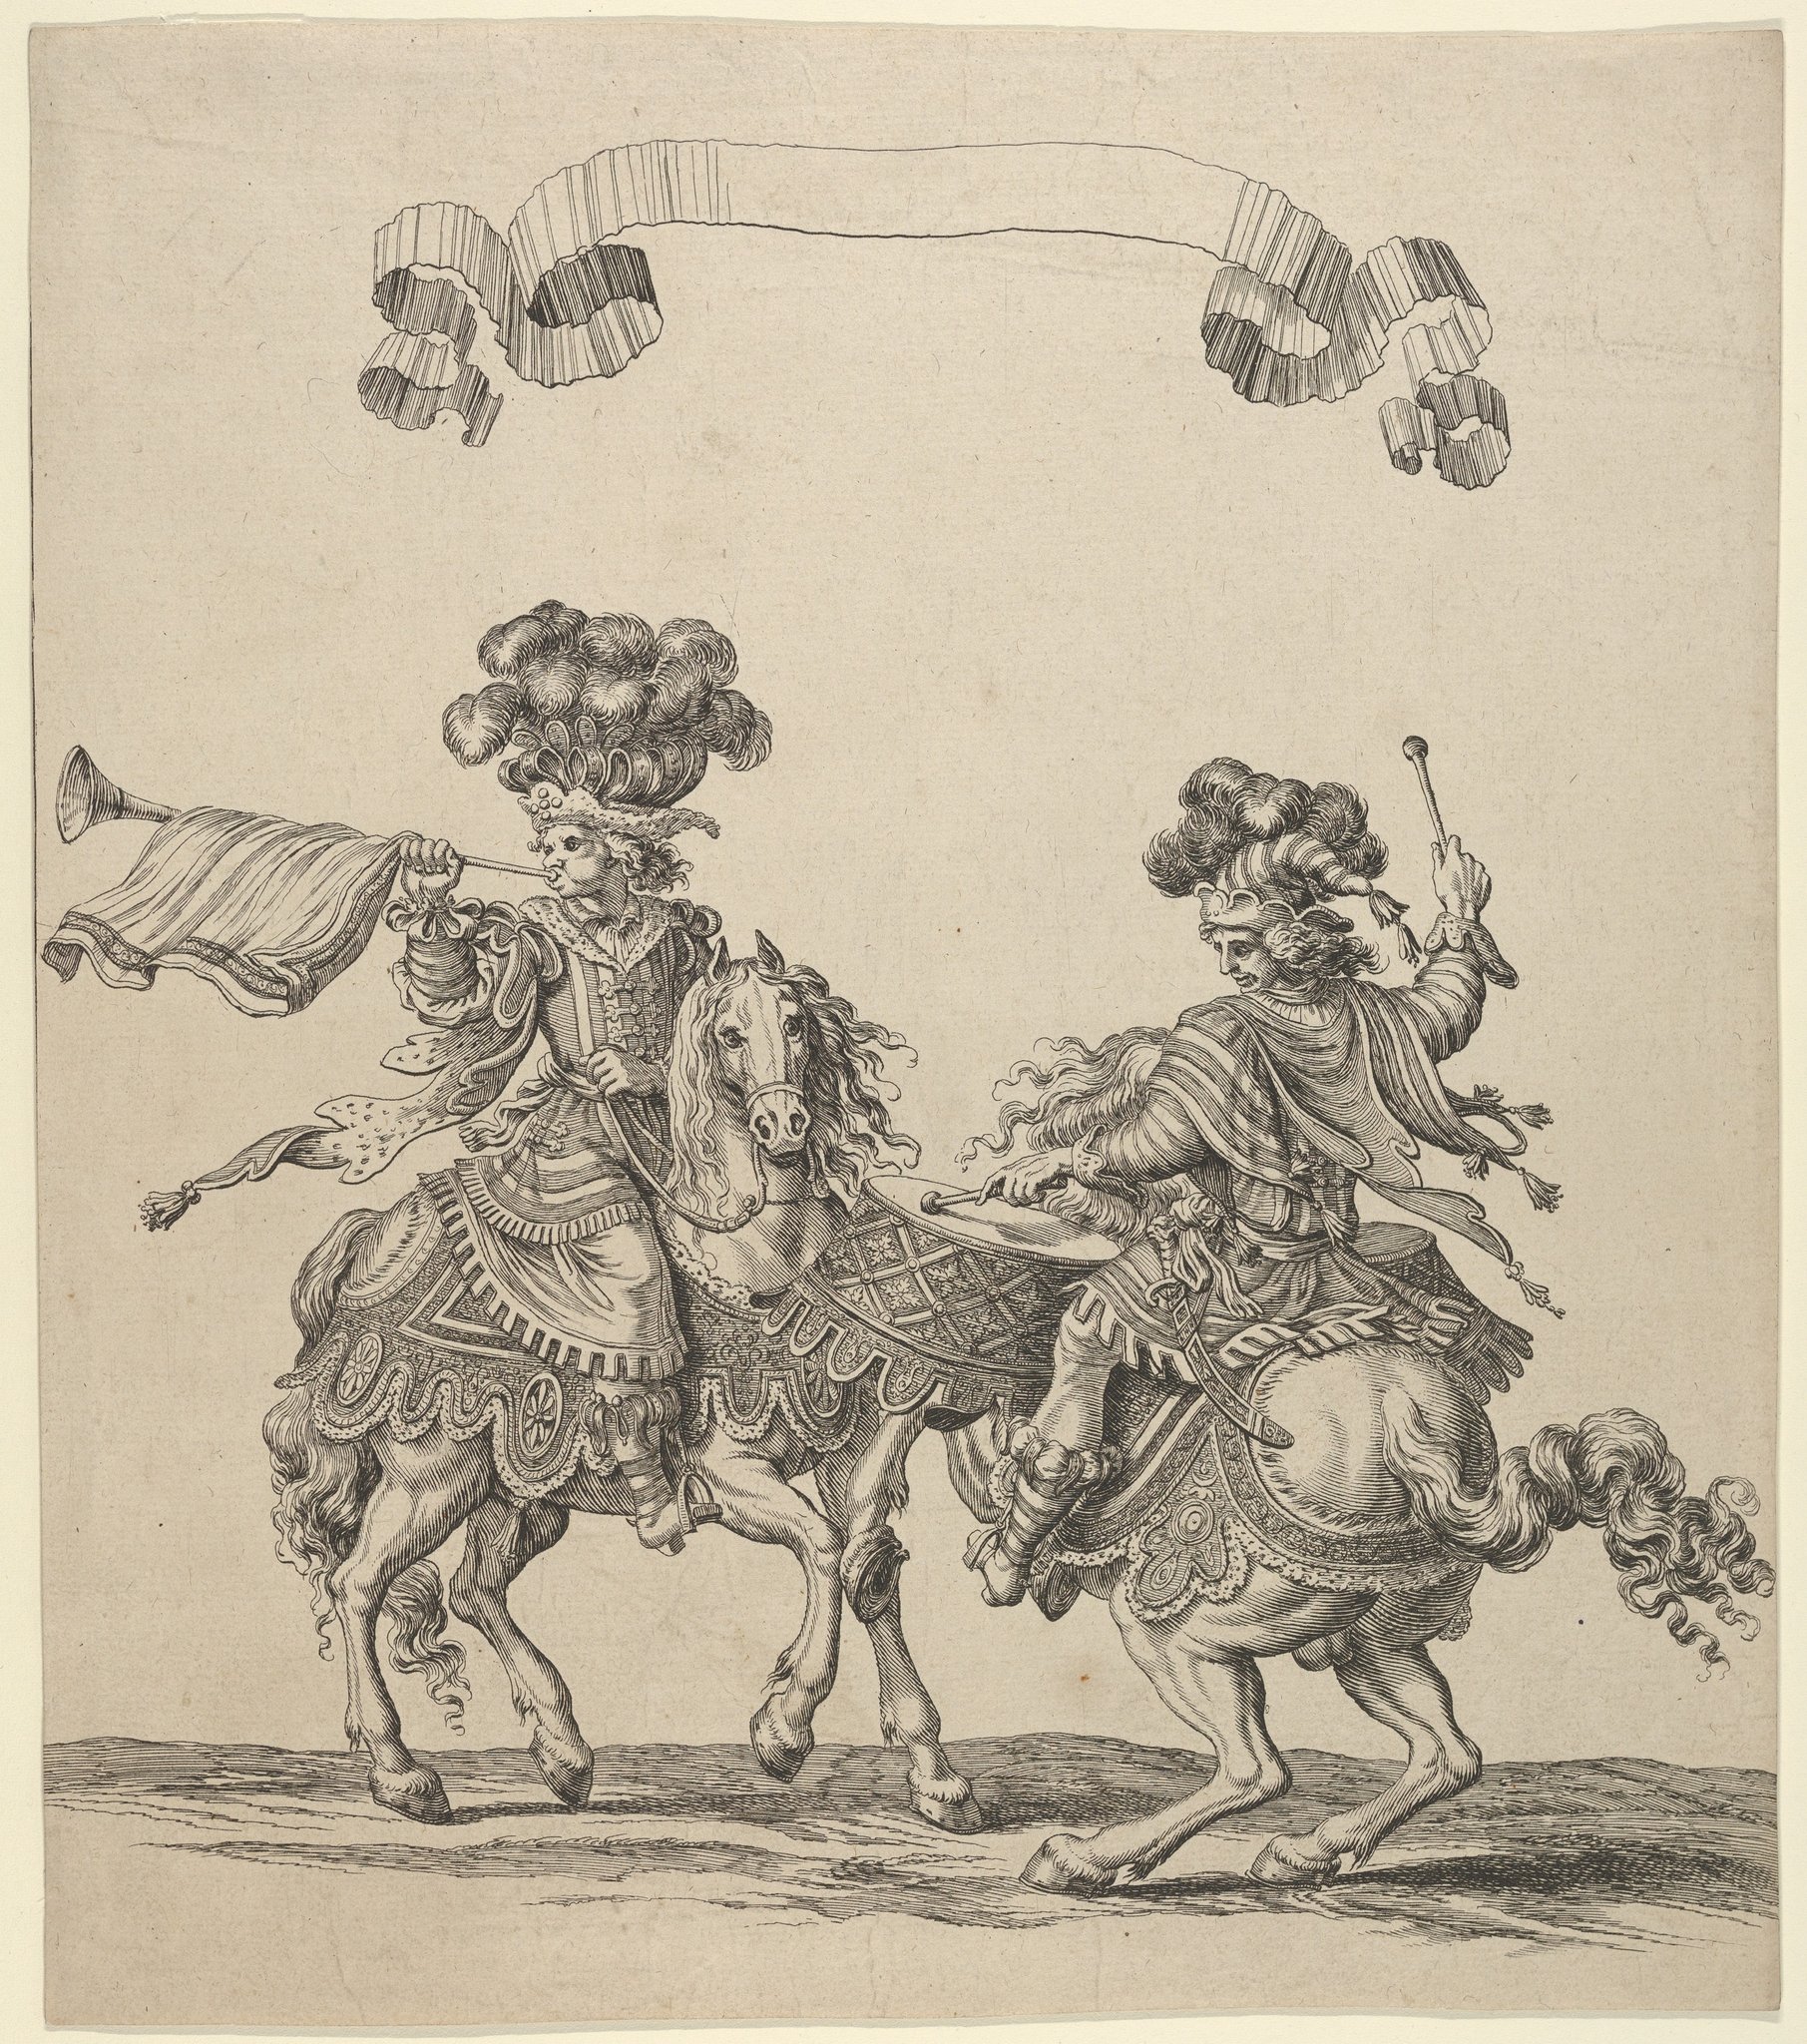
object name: print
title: Plate 30 from "Course des Tetes et Bagues"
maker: françois chauveau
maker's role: artist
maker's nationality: french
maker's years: 1613-1676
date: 1662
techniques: etching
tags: men,drums,trumpets,horses